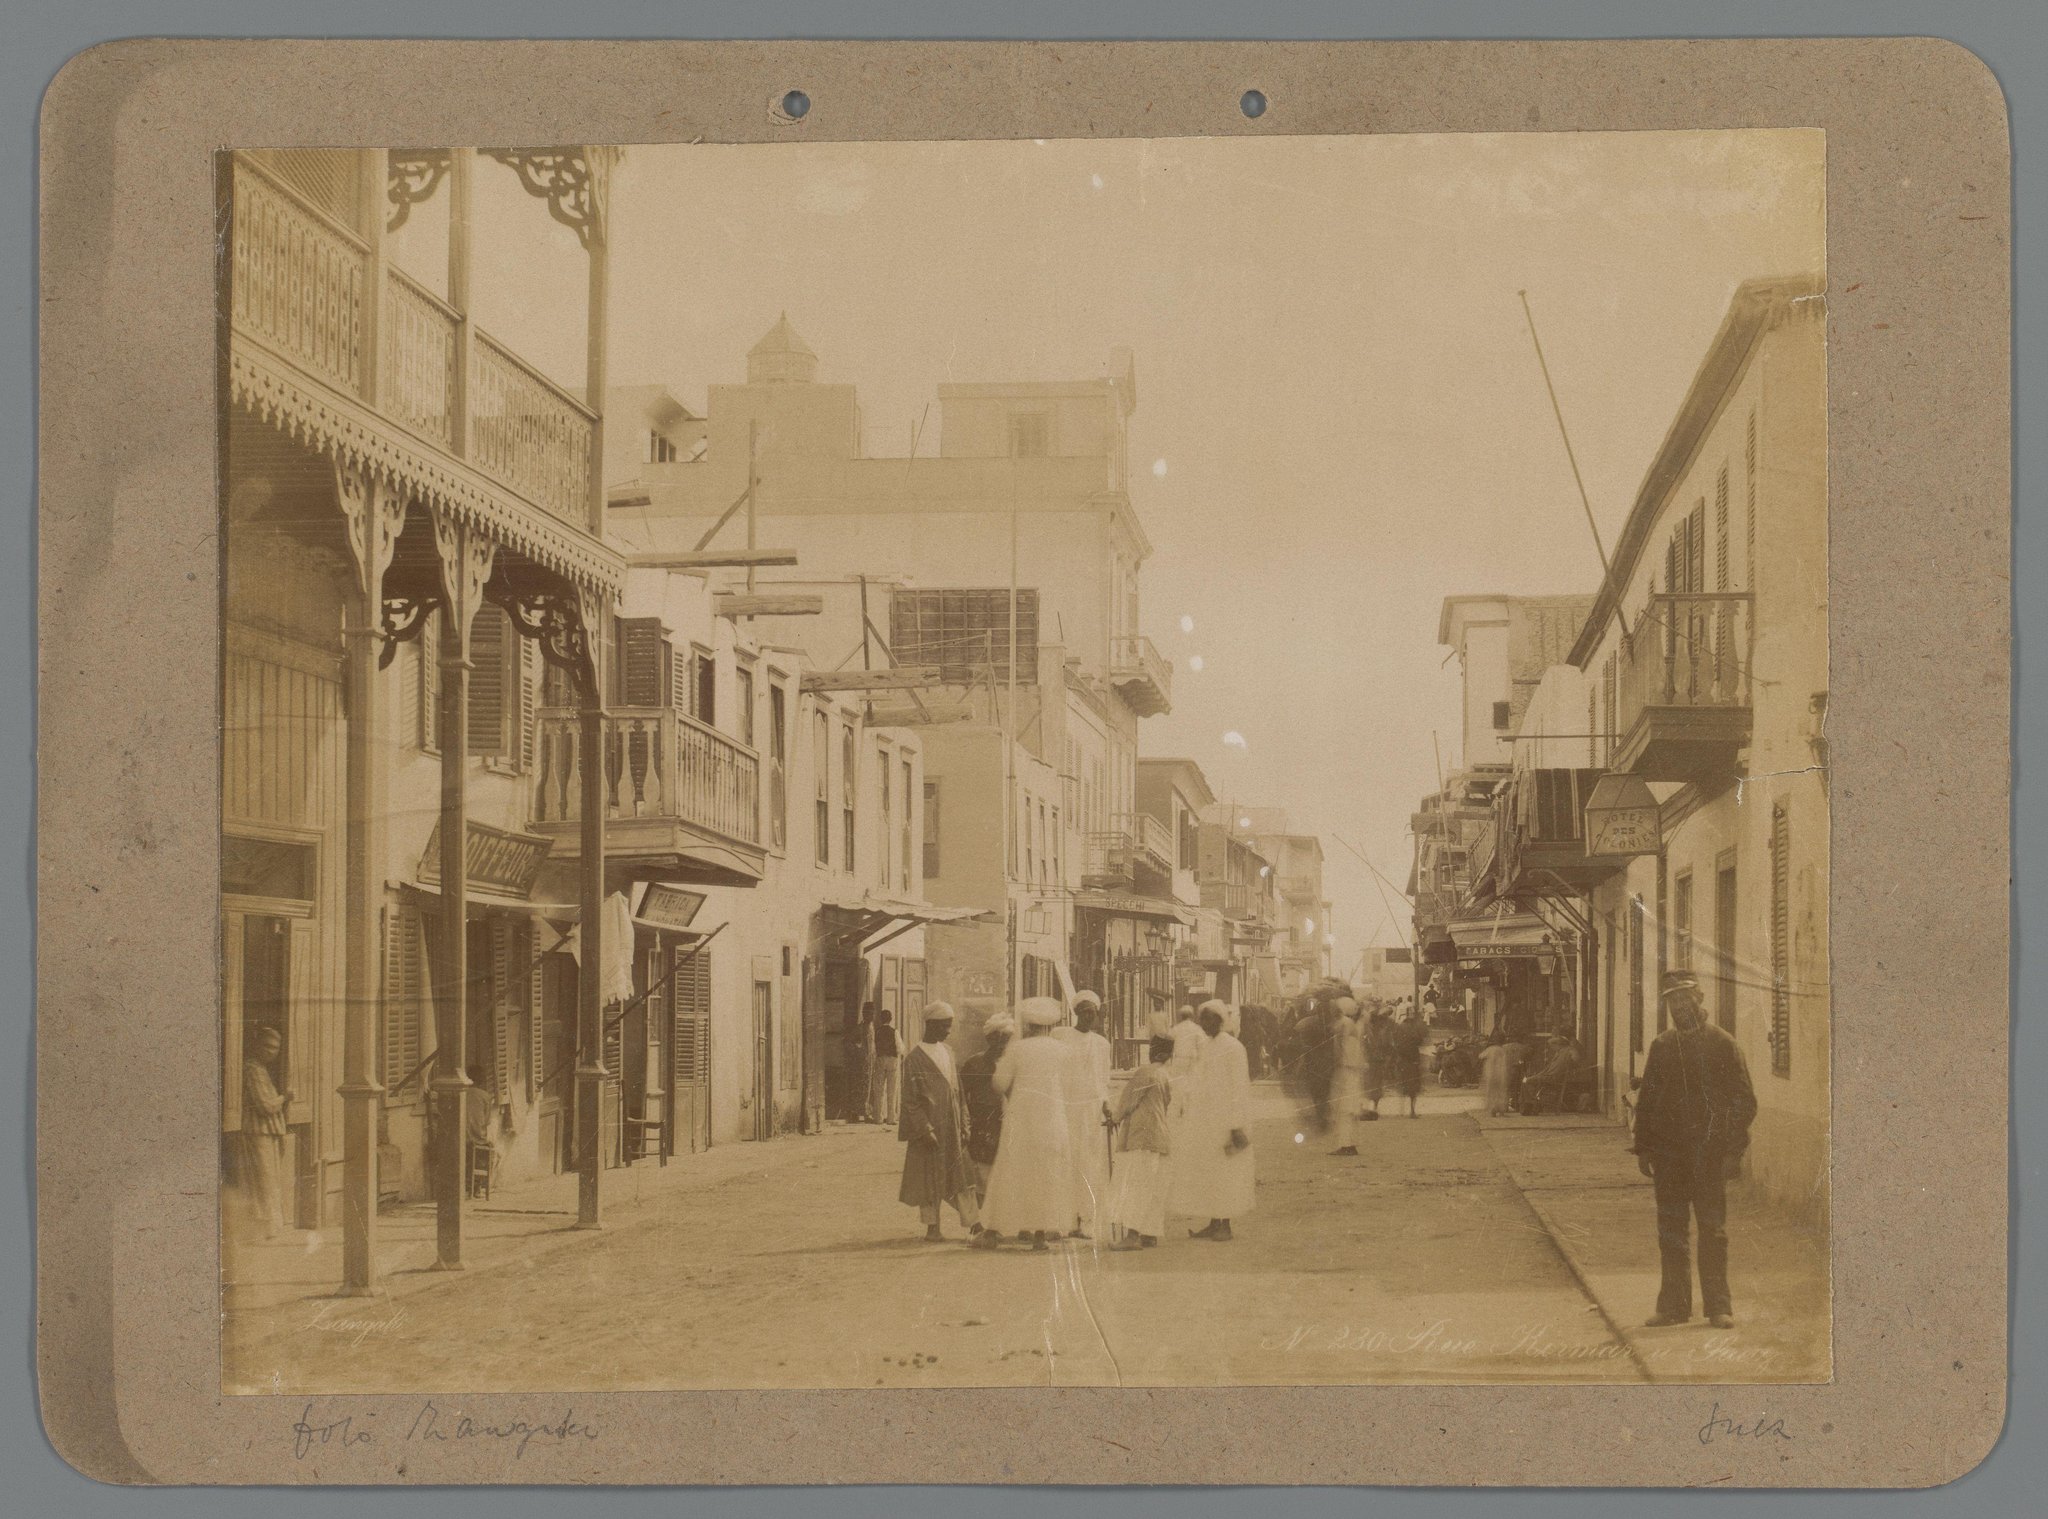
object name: photograph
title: Rue Kormar a Suez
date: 1870-1910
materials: cardboard, paper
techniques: albumen print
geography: suez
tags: locations for trading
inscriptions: number: ‘No 230’